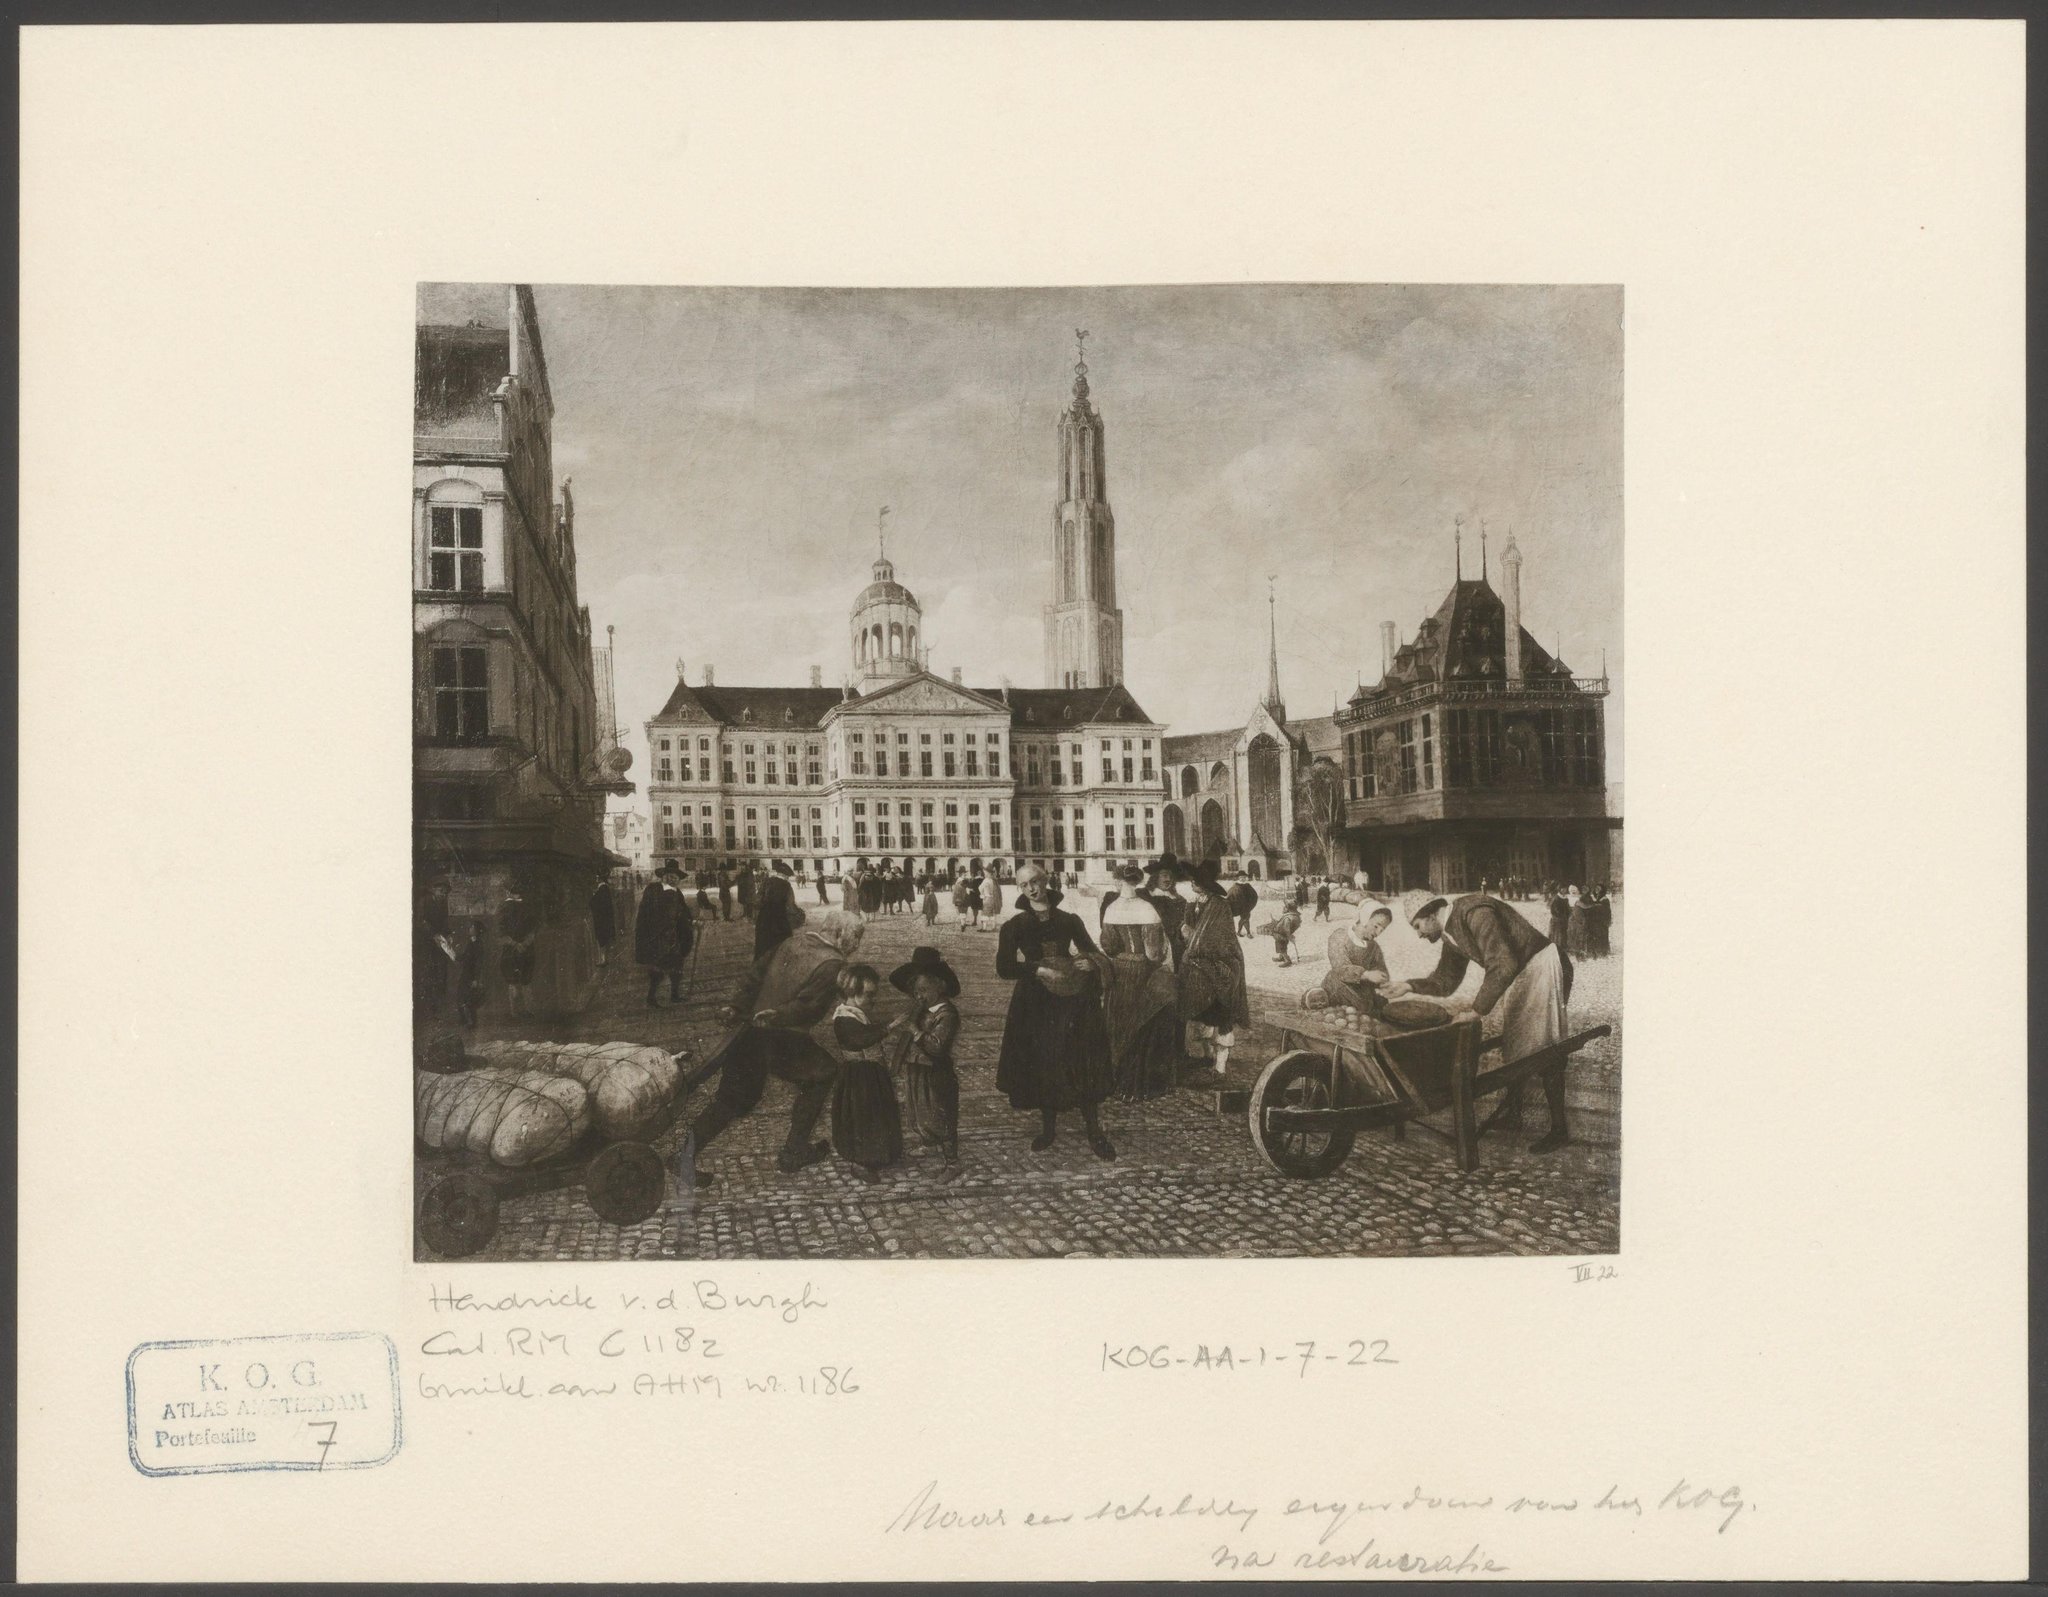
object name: reproduction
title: Fotoreproductie van een gezicht op het Stadhuis, de Nieuwe Kerk en de Waag op de Dam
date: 1900-1950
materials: paper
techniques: gelatin silver print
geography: amsterdam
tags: square, place, circus, etc., city-view in general; 'veduta', church (exterior), townhall, weigh-house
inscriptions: inscription: ‘Hendrik v.d. Burgh (...) KOG. / na restauratie’, collector's mark: ‘7’ Lugt 1641b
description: Onderwerpsrubriek binnen de Atlas Amsterdam: Dam (voor 1835).